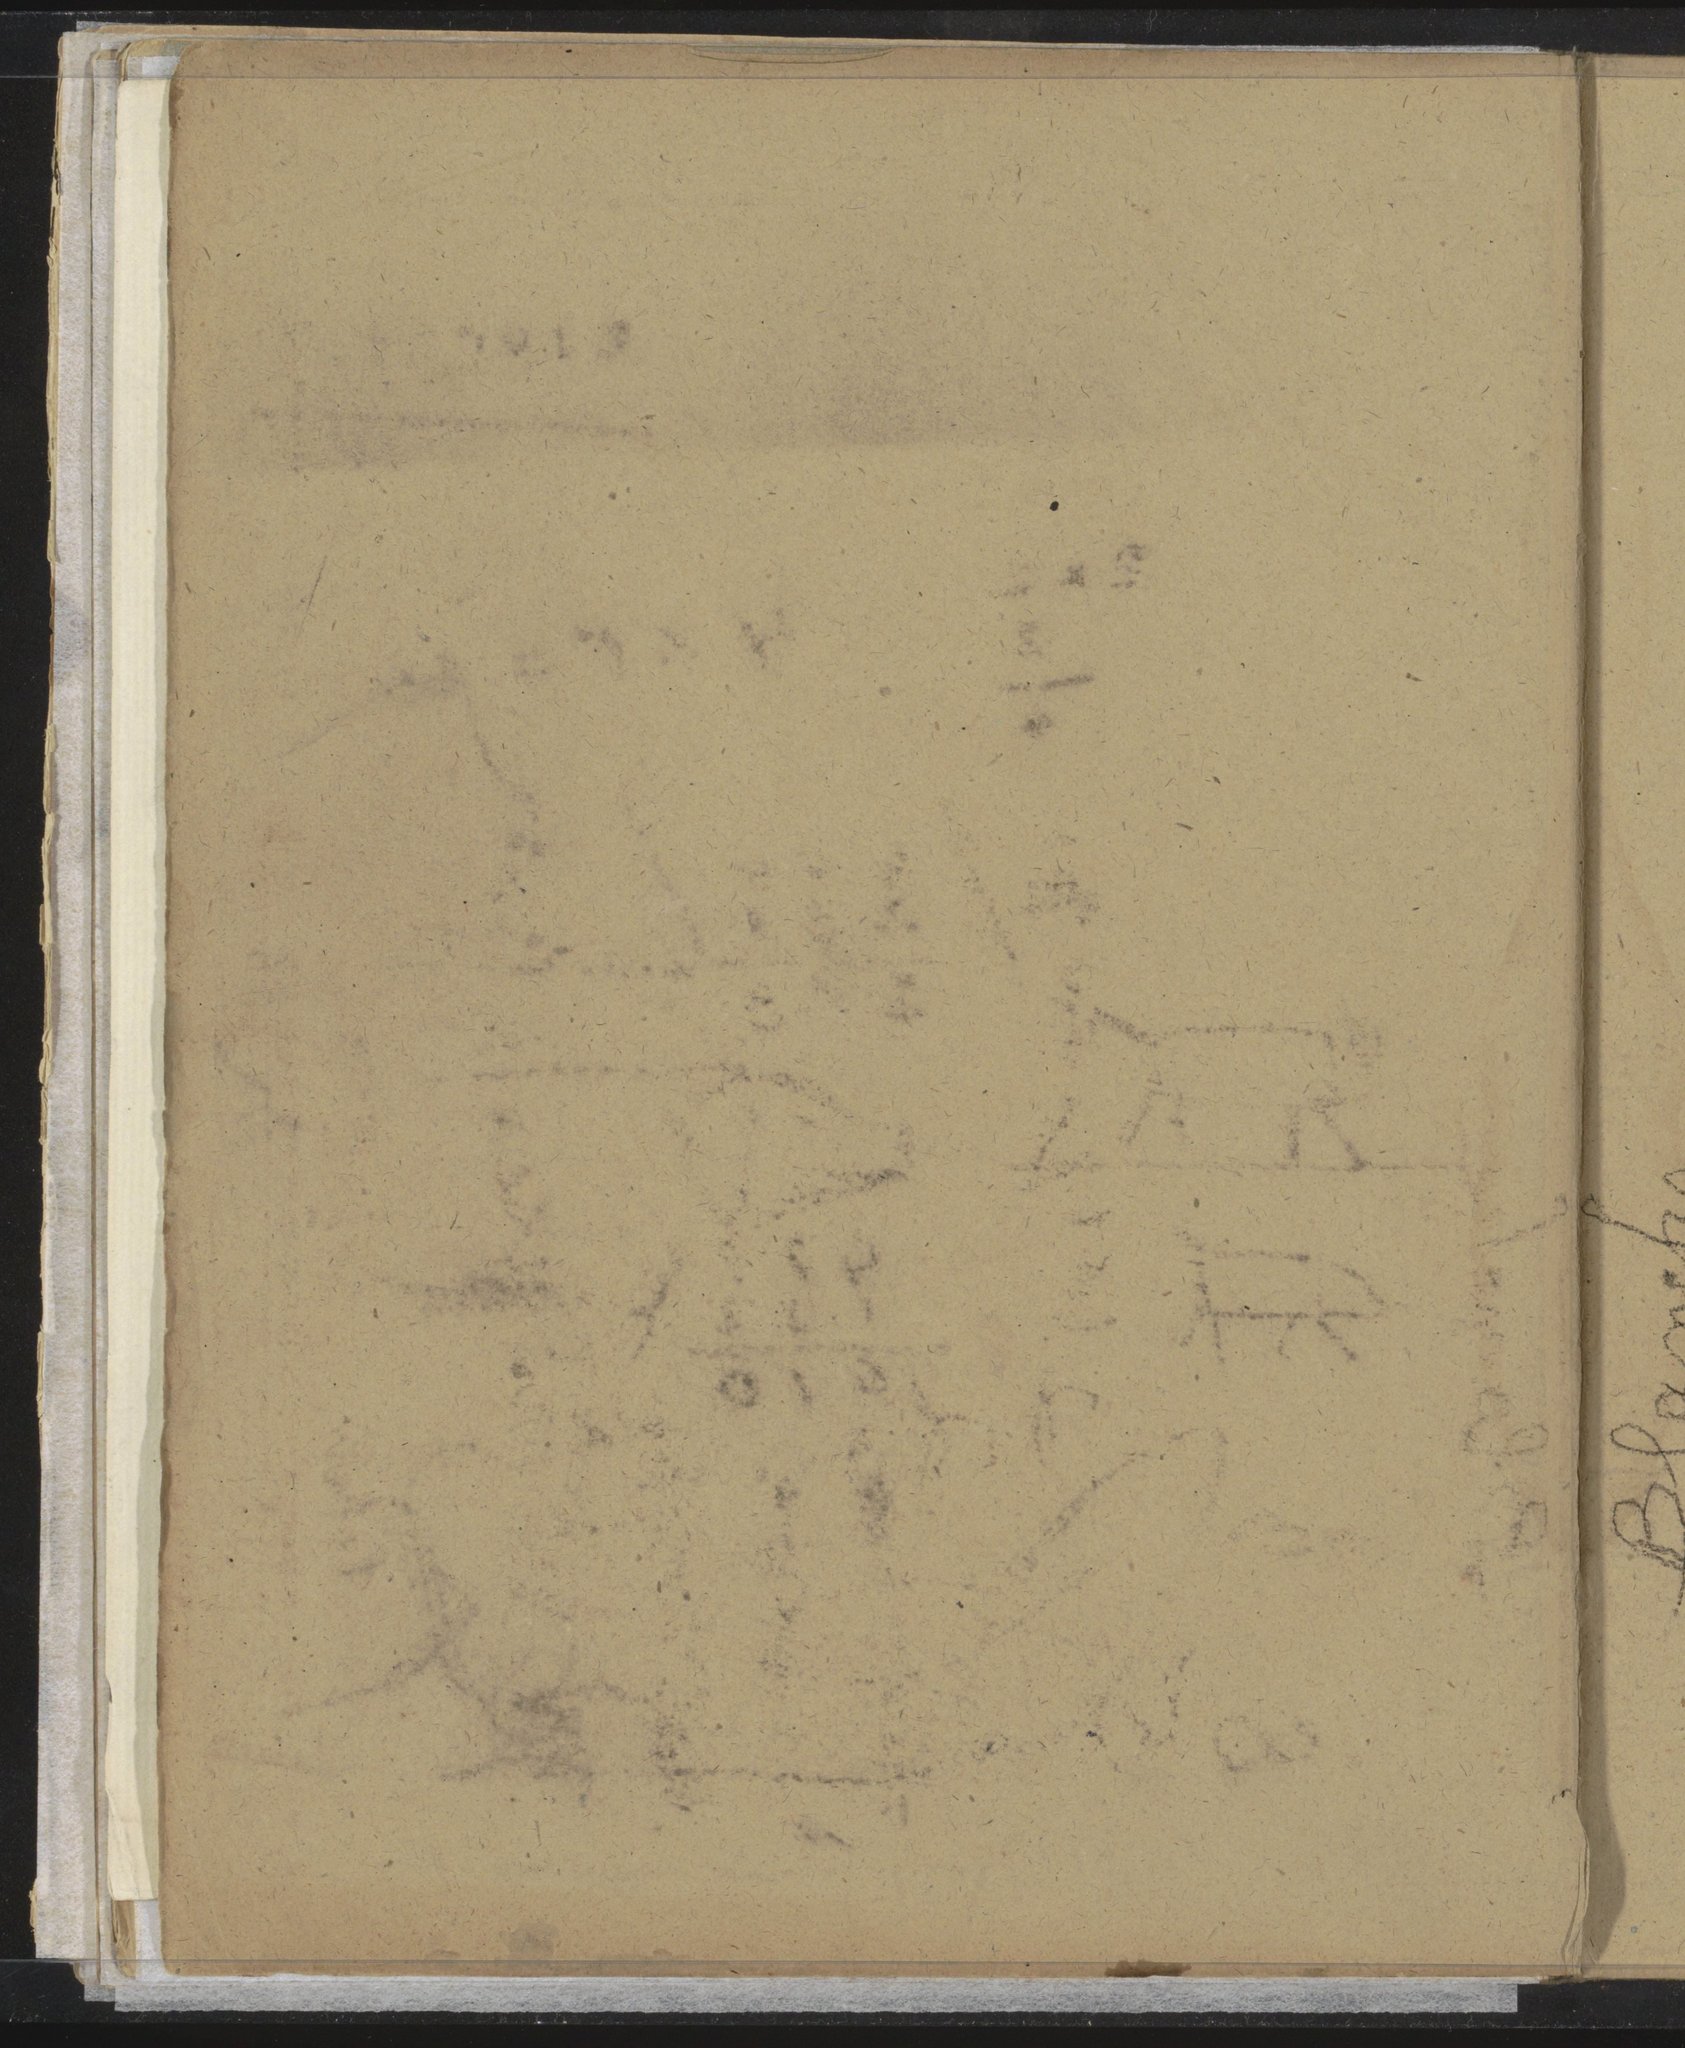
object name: sketchbook leaf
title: Abklatsch van de tekeningen en annotaties op pagina 79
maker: willem witsen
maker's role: draughtsman, painter, print maker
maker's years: 1860-1923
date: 1887-1891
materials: paper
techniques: printmaking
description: Pagina 78 uit een schetsboek met 29 bladen.